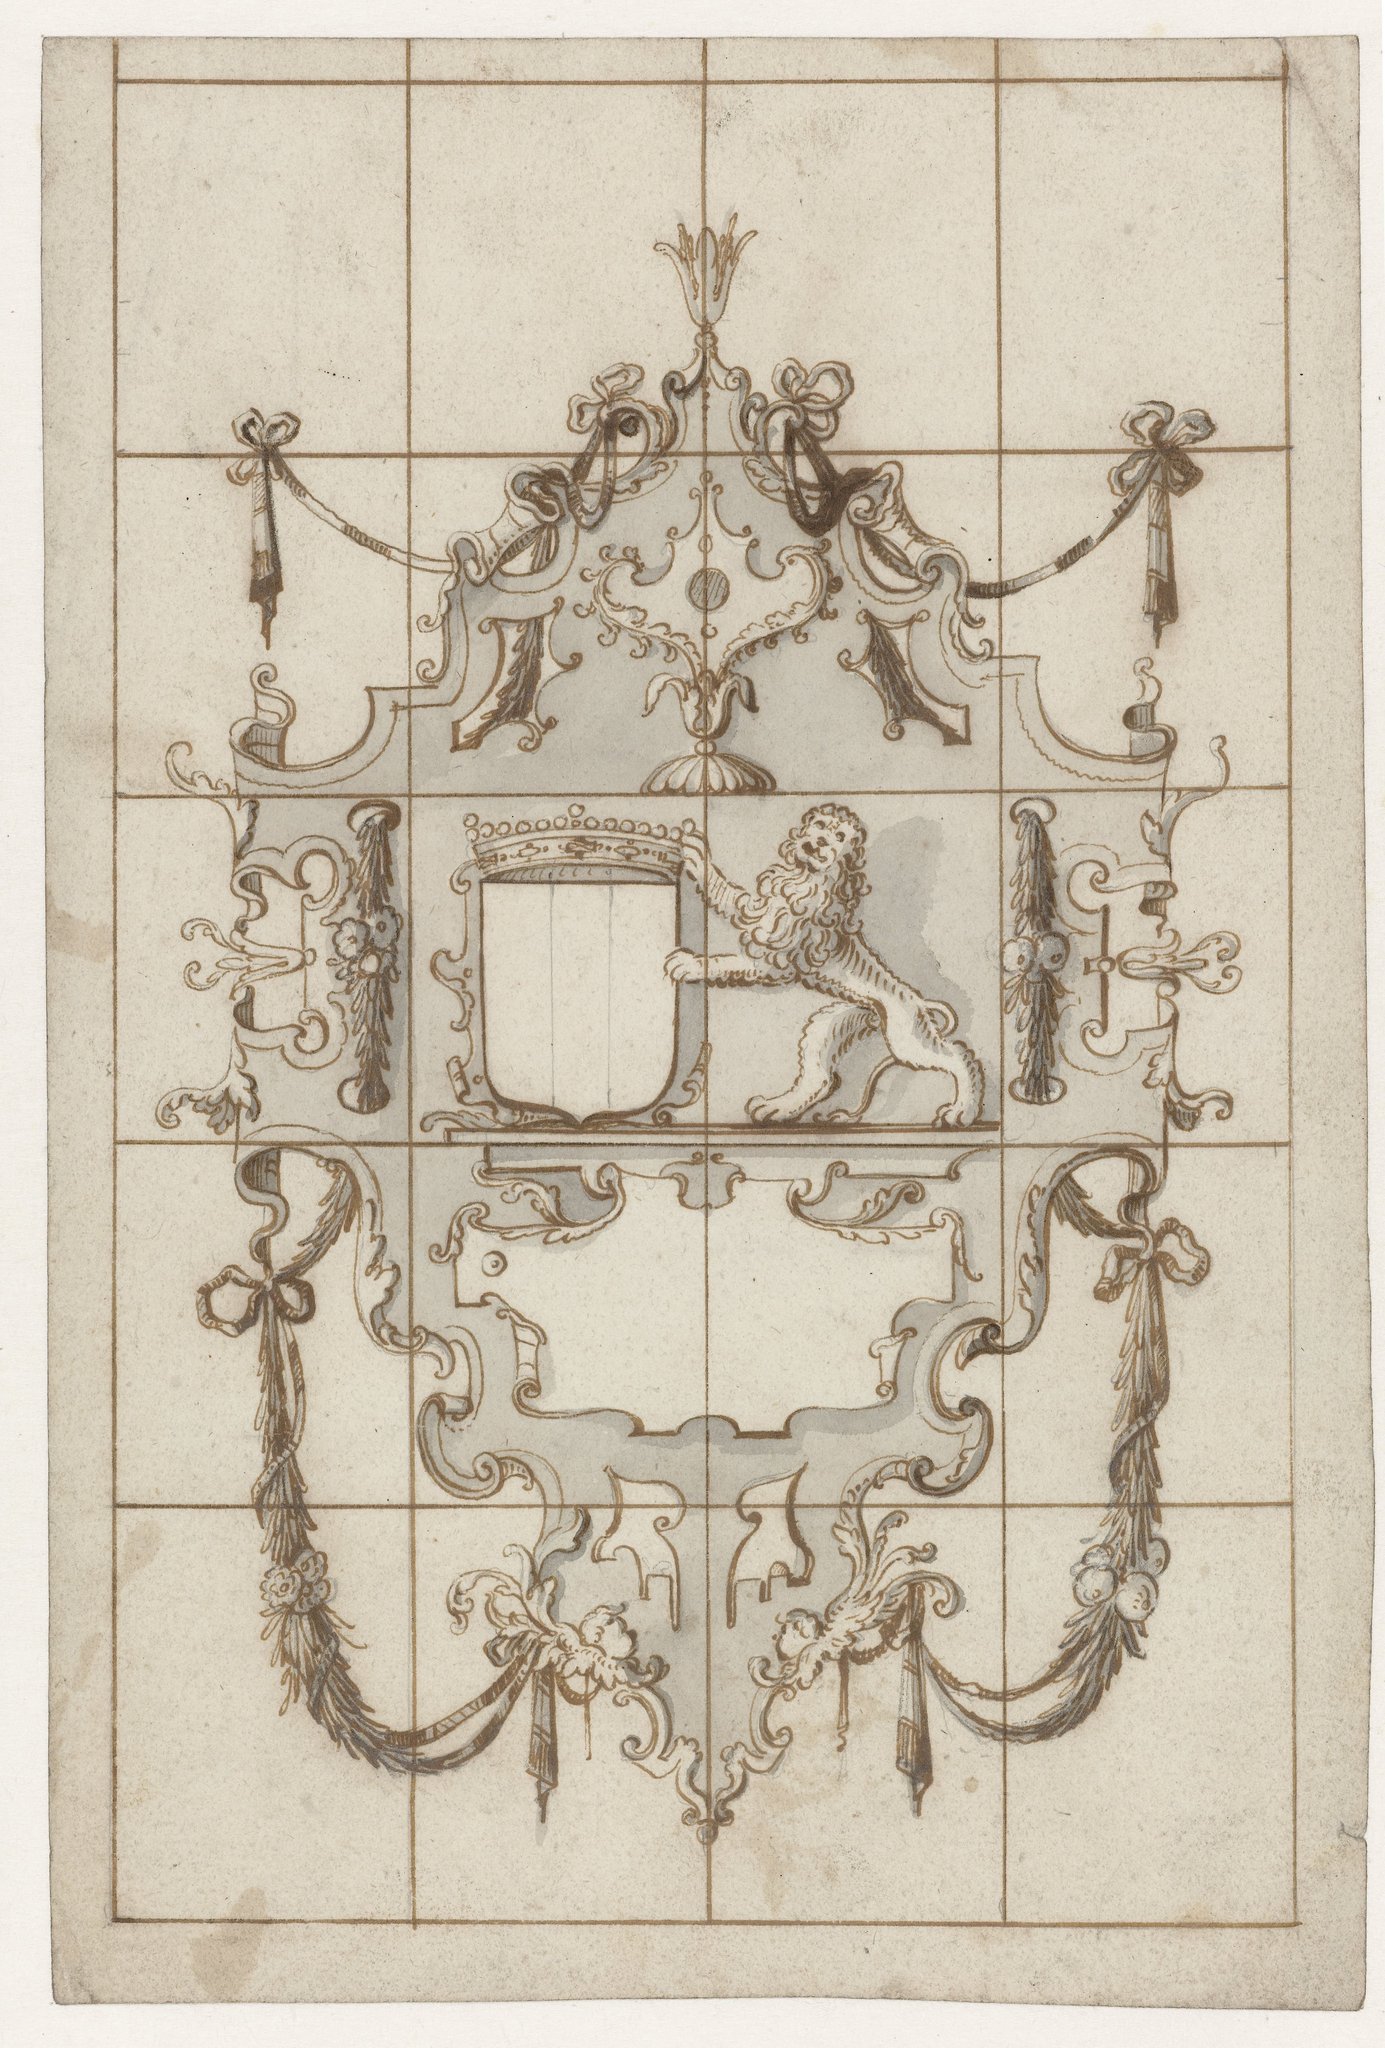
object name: design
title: Ontwerp voor een glasraam met een wapenschild en een leeuw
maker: pieter jansz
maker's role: draughtsman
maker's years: 1602-1672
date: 1630-1672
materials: graphite, ink, paper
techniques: brush, pen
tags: ornament ~ cartouche, beasts of prey, predatory animals: lion (+ heraldic animals), armorial bearing, heraldry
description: Ontwerp voor een glasraam met een blanco wapenschild en een klimmende leeuw.